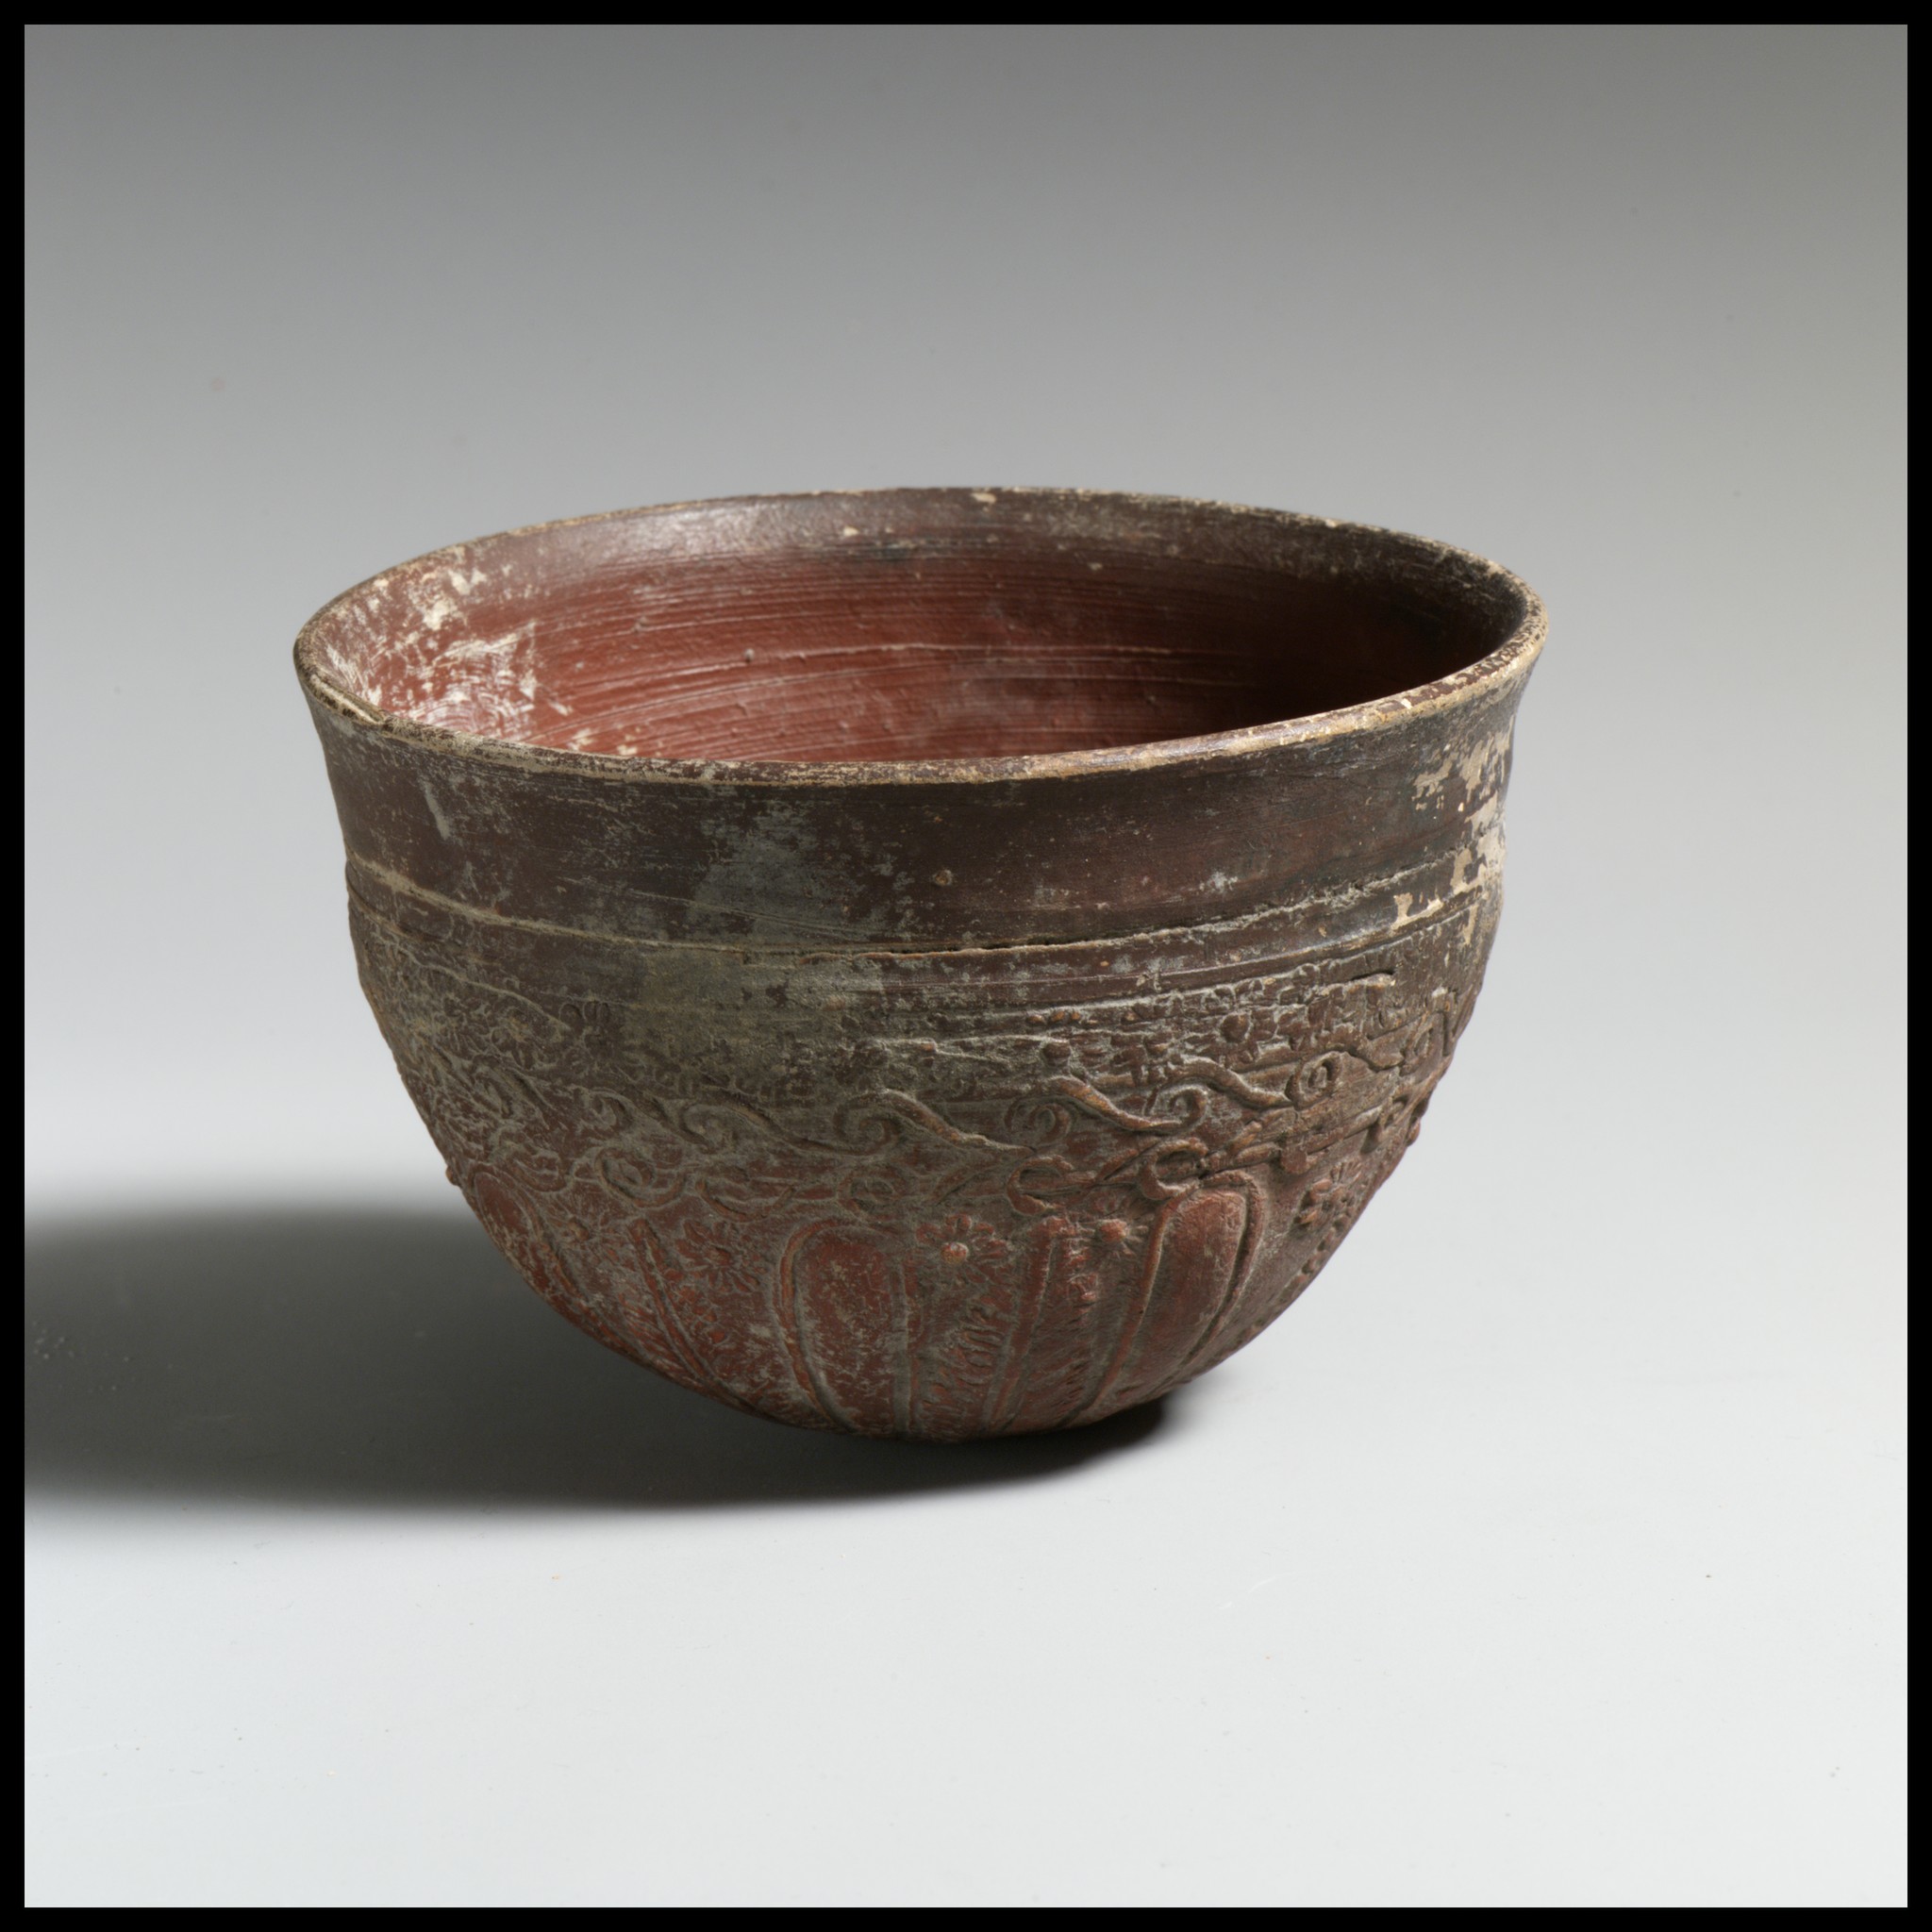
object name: megarian bowl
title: Terracotta Megarian bowl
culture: greek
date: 100-1 BCE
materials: terracotta